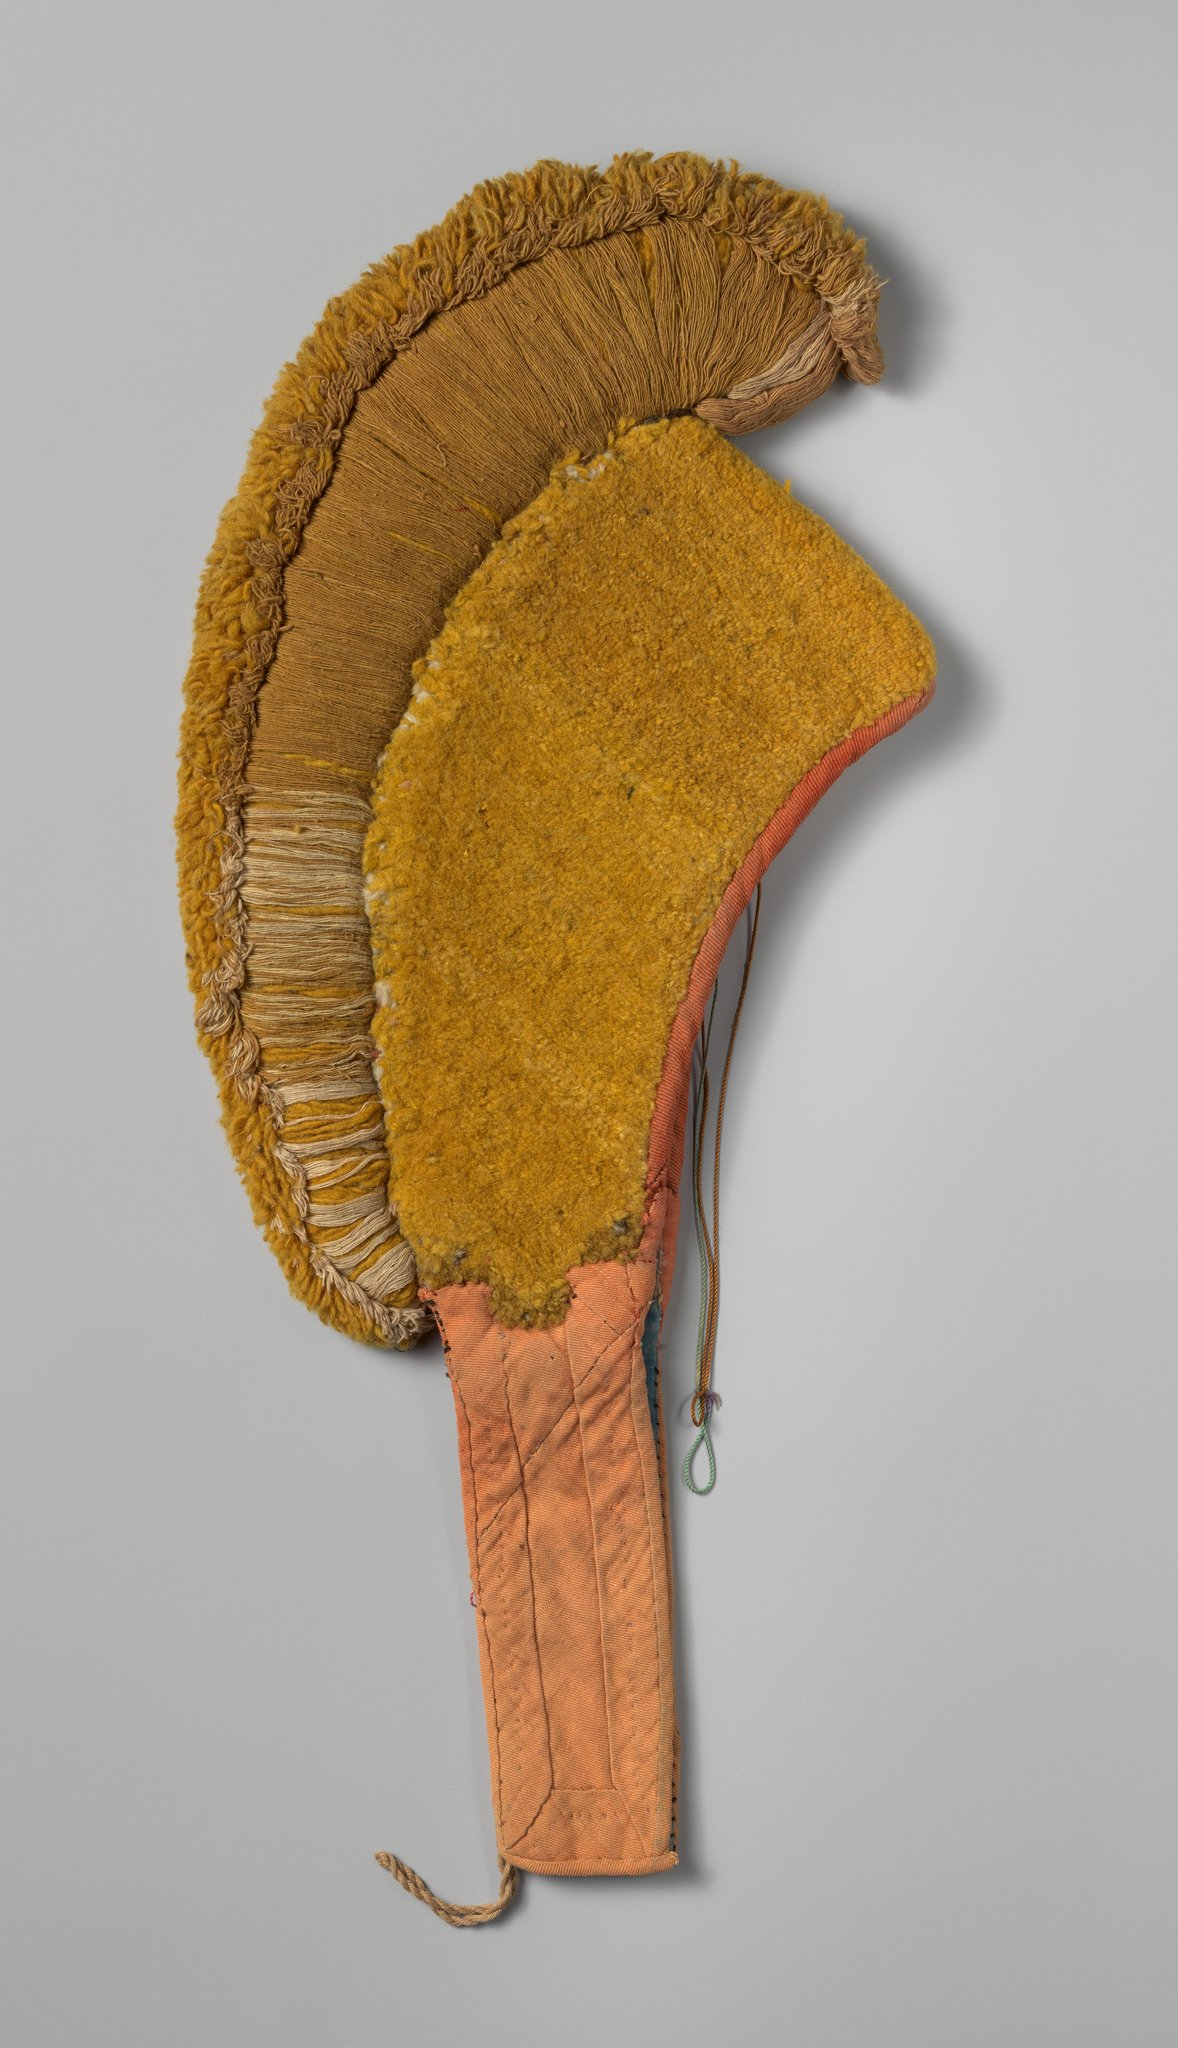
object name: helmet shaped hat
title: Helmet-Shaped Hat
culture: tibetan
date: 1801-1900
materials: cotton, wool